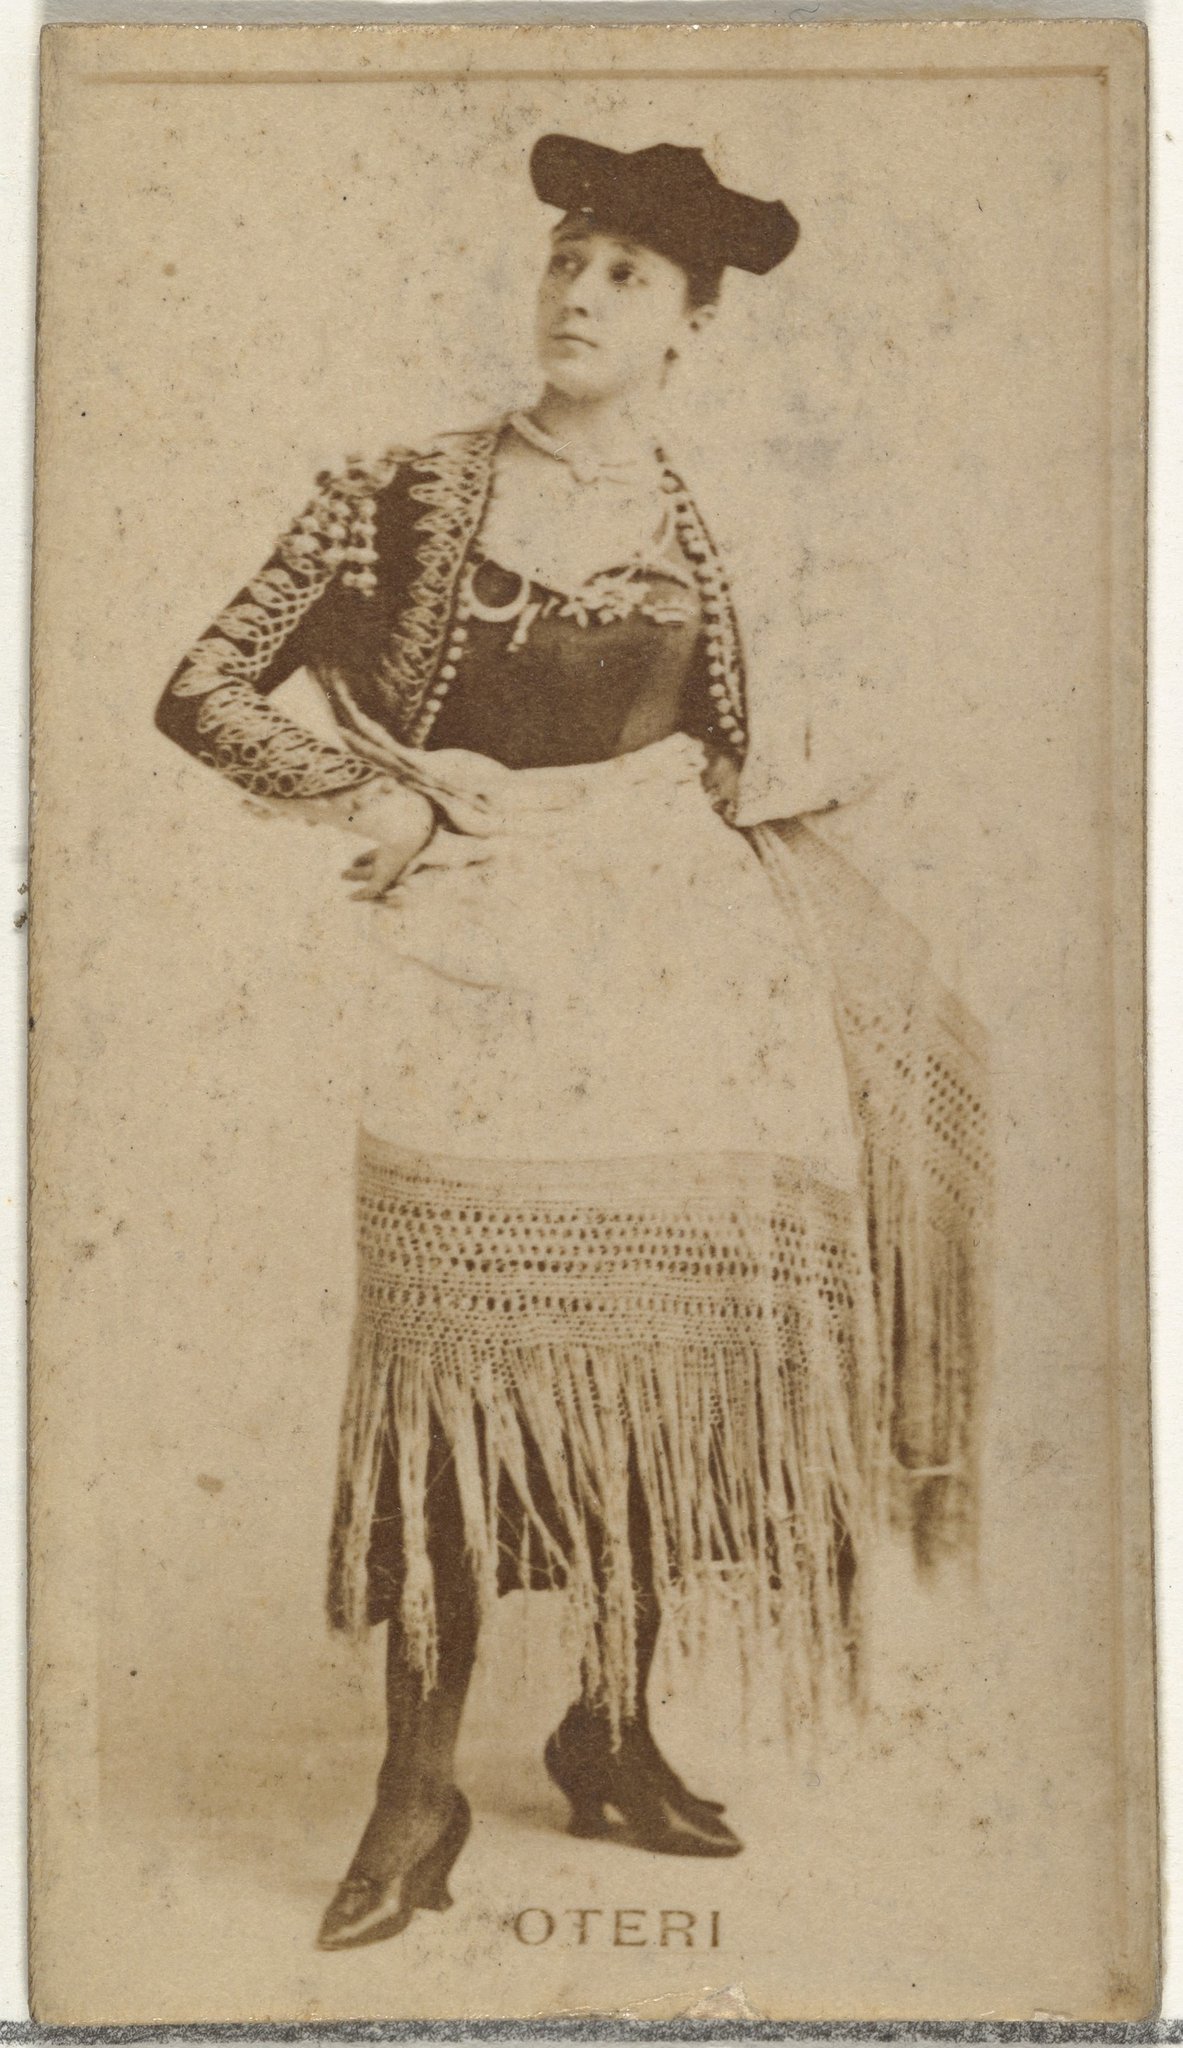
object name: photograph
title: Miss Oteri, from the Actors and Actresses series (N145-8) issued by Duke Sons & Co. to promote Duke Cigarettes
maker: w. duke, sons & co.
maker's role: publisher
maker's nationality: american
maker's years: 1870-1920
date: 1891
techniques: albumen silver print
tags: portraits,women,actresses